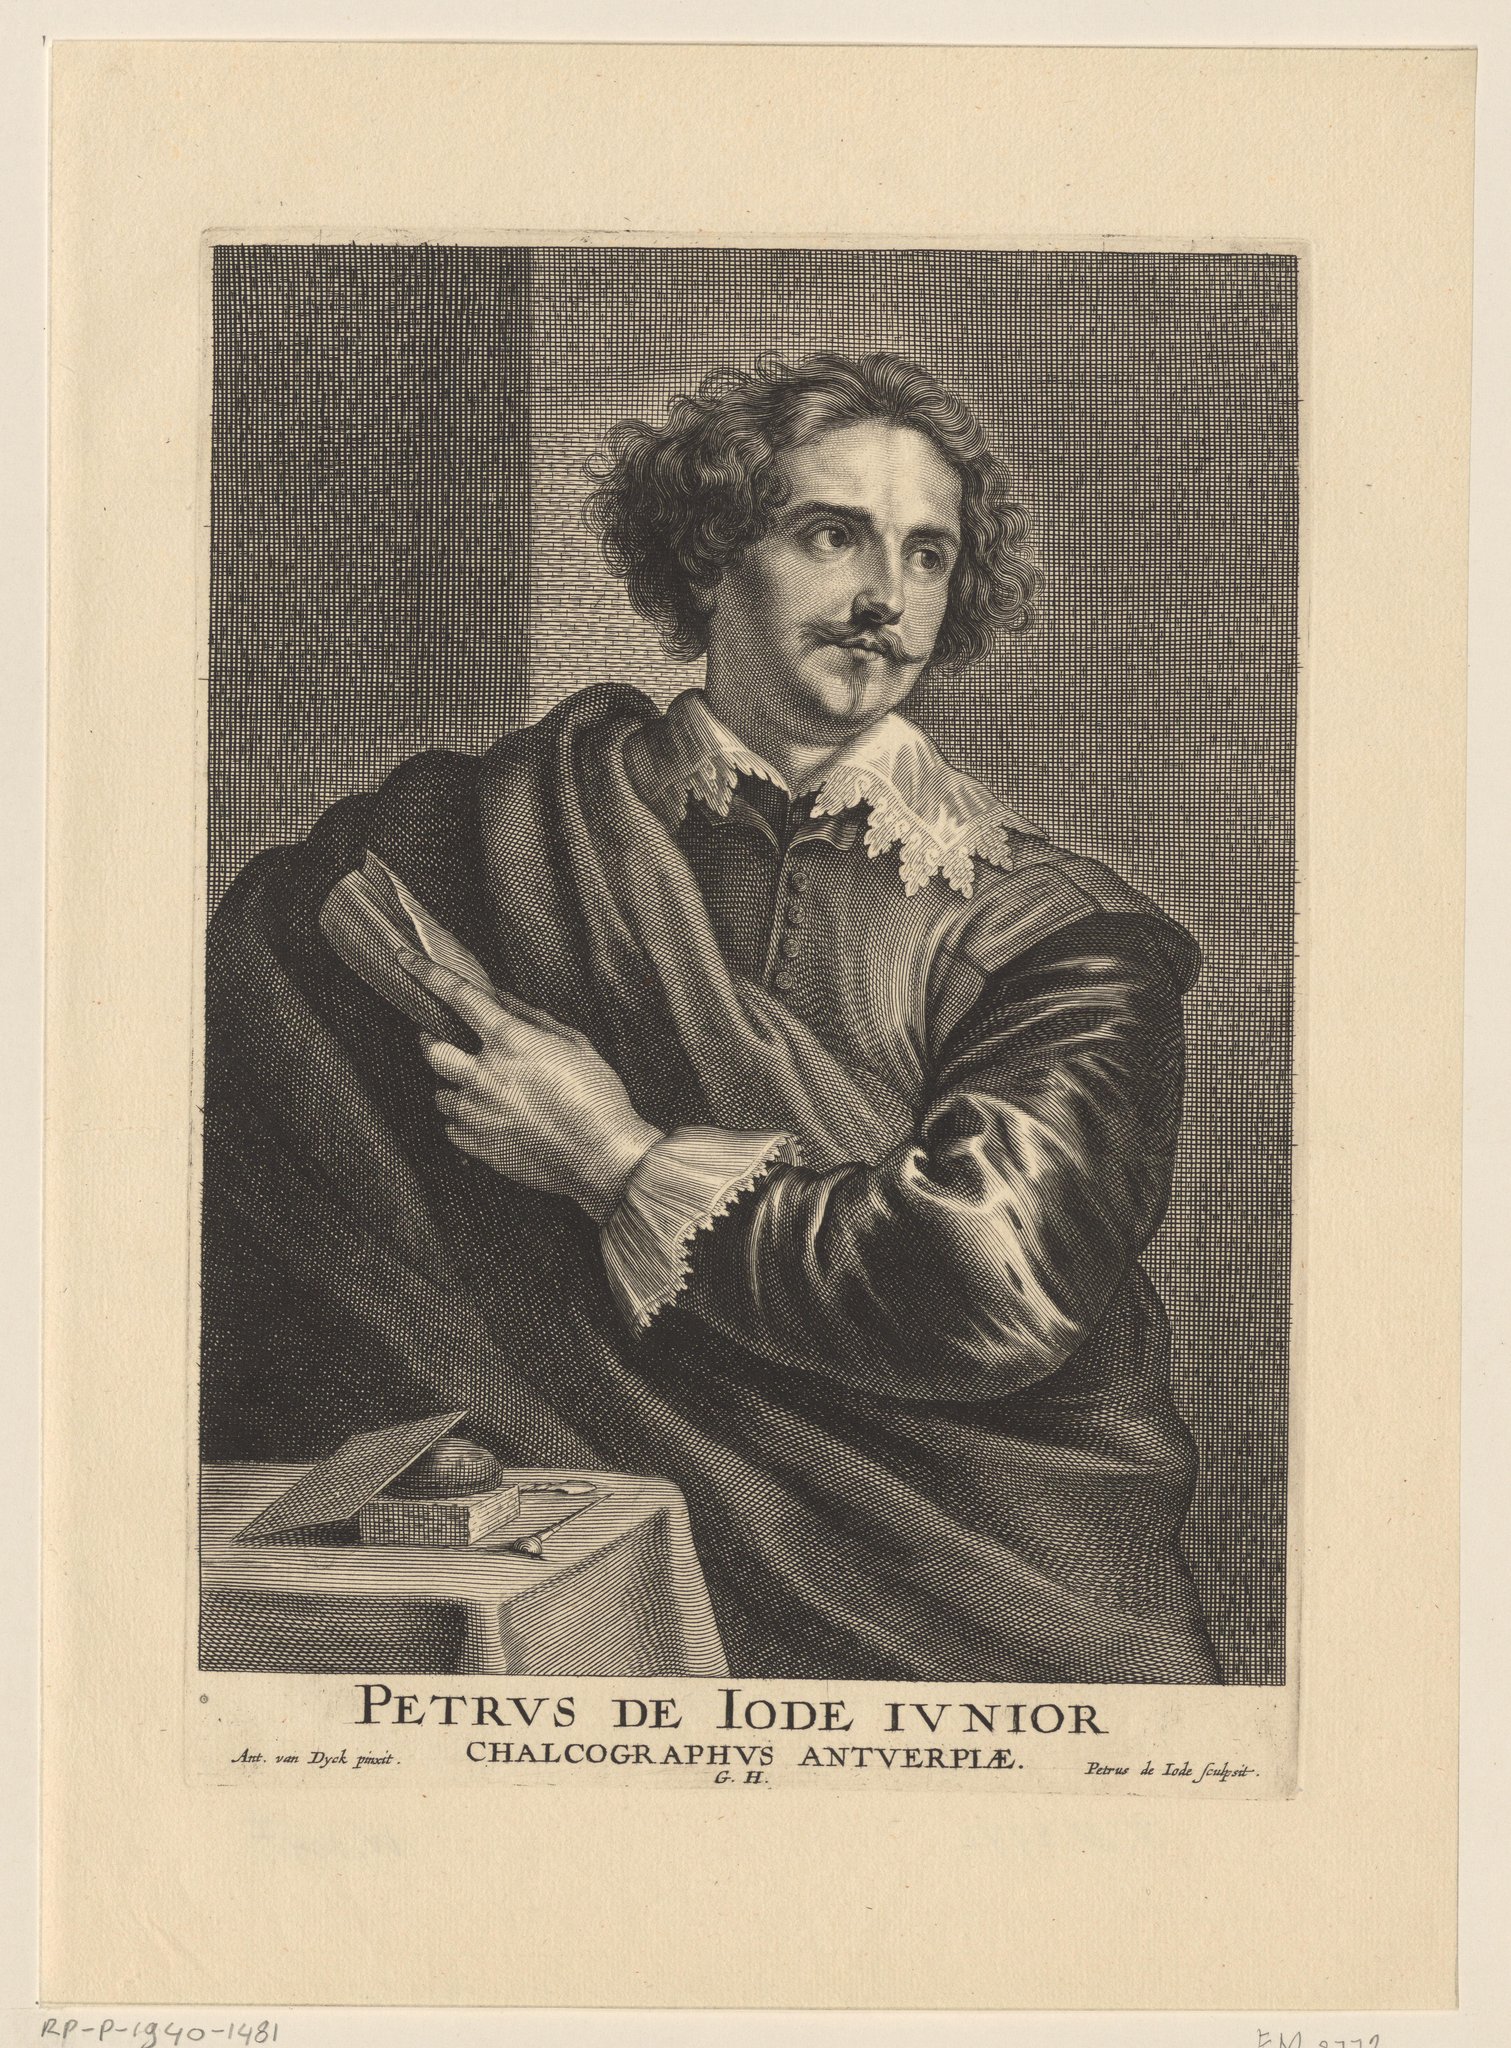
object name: print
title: Portret van Pieter de Jode II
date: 1628-1670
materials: paper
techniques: engraving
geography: antwerp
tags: antwerp, print maker, historical persons, portrait, self-portrait of graphic artist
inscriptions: collector's mark: Lugt 2760, collector's mark: Lugt 2166